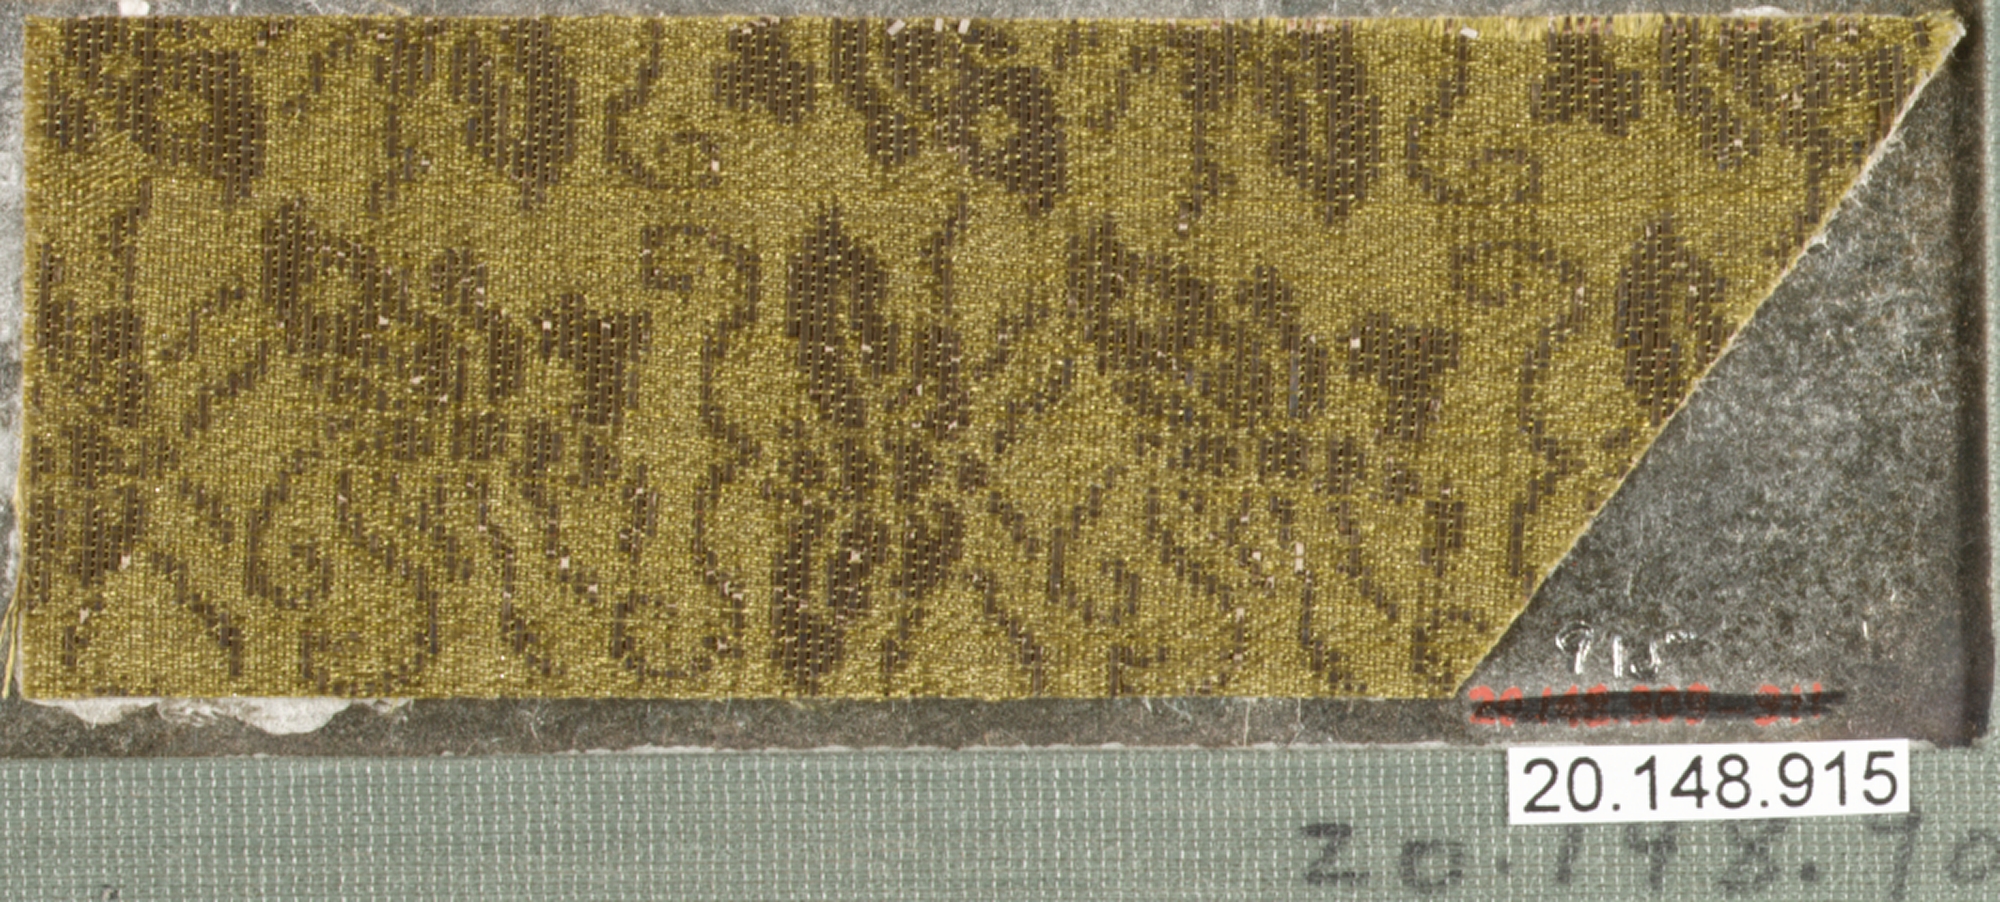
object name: piece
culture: japanese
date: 1701-1800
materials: silk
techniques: compound weave